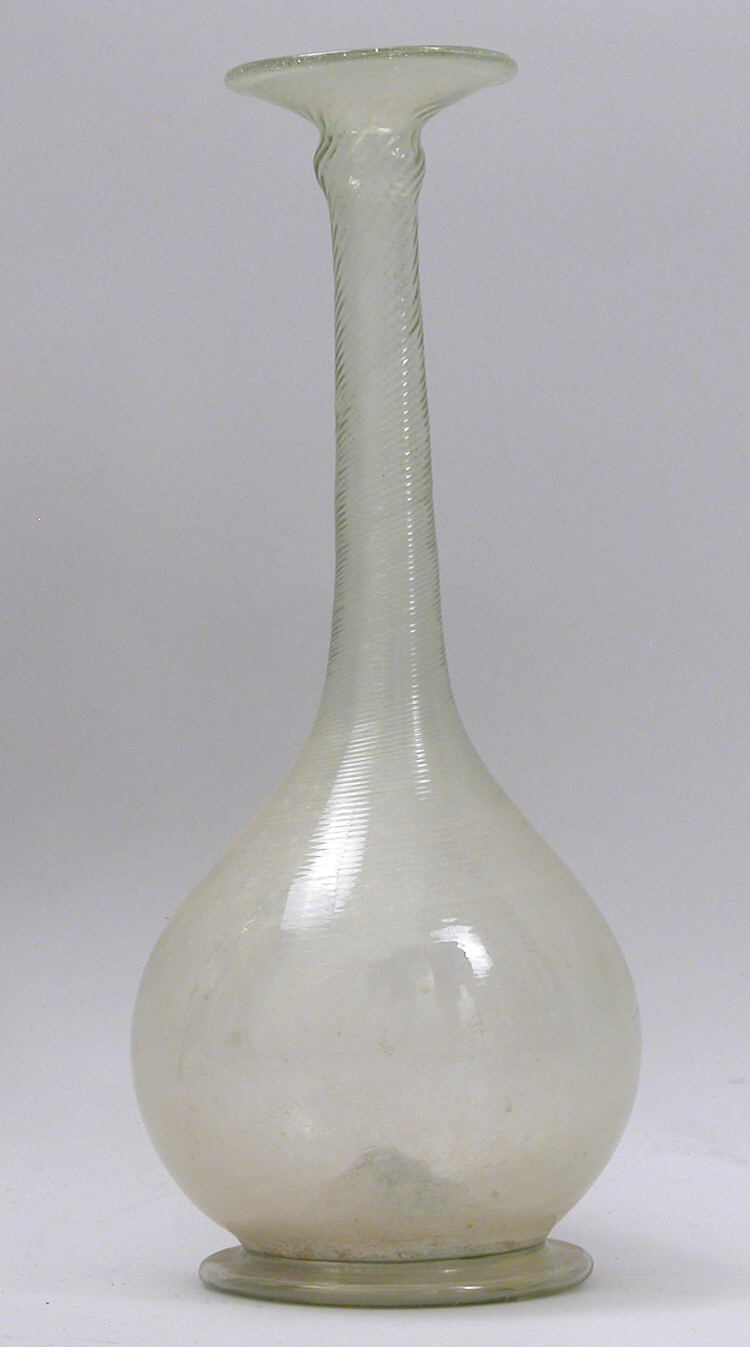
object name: bottle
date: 1701-1900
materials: glass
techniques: glassblowing, molding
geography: iran